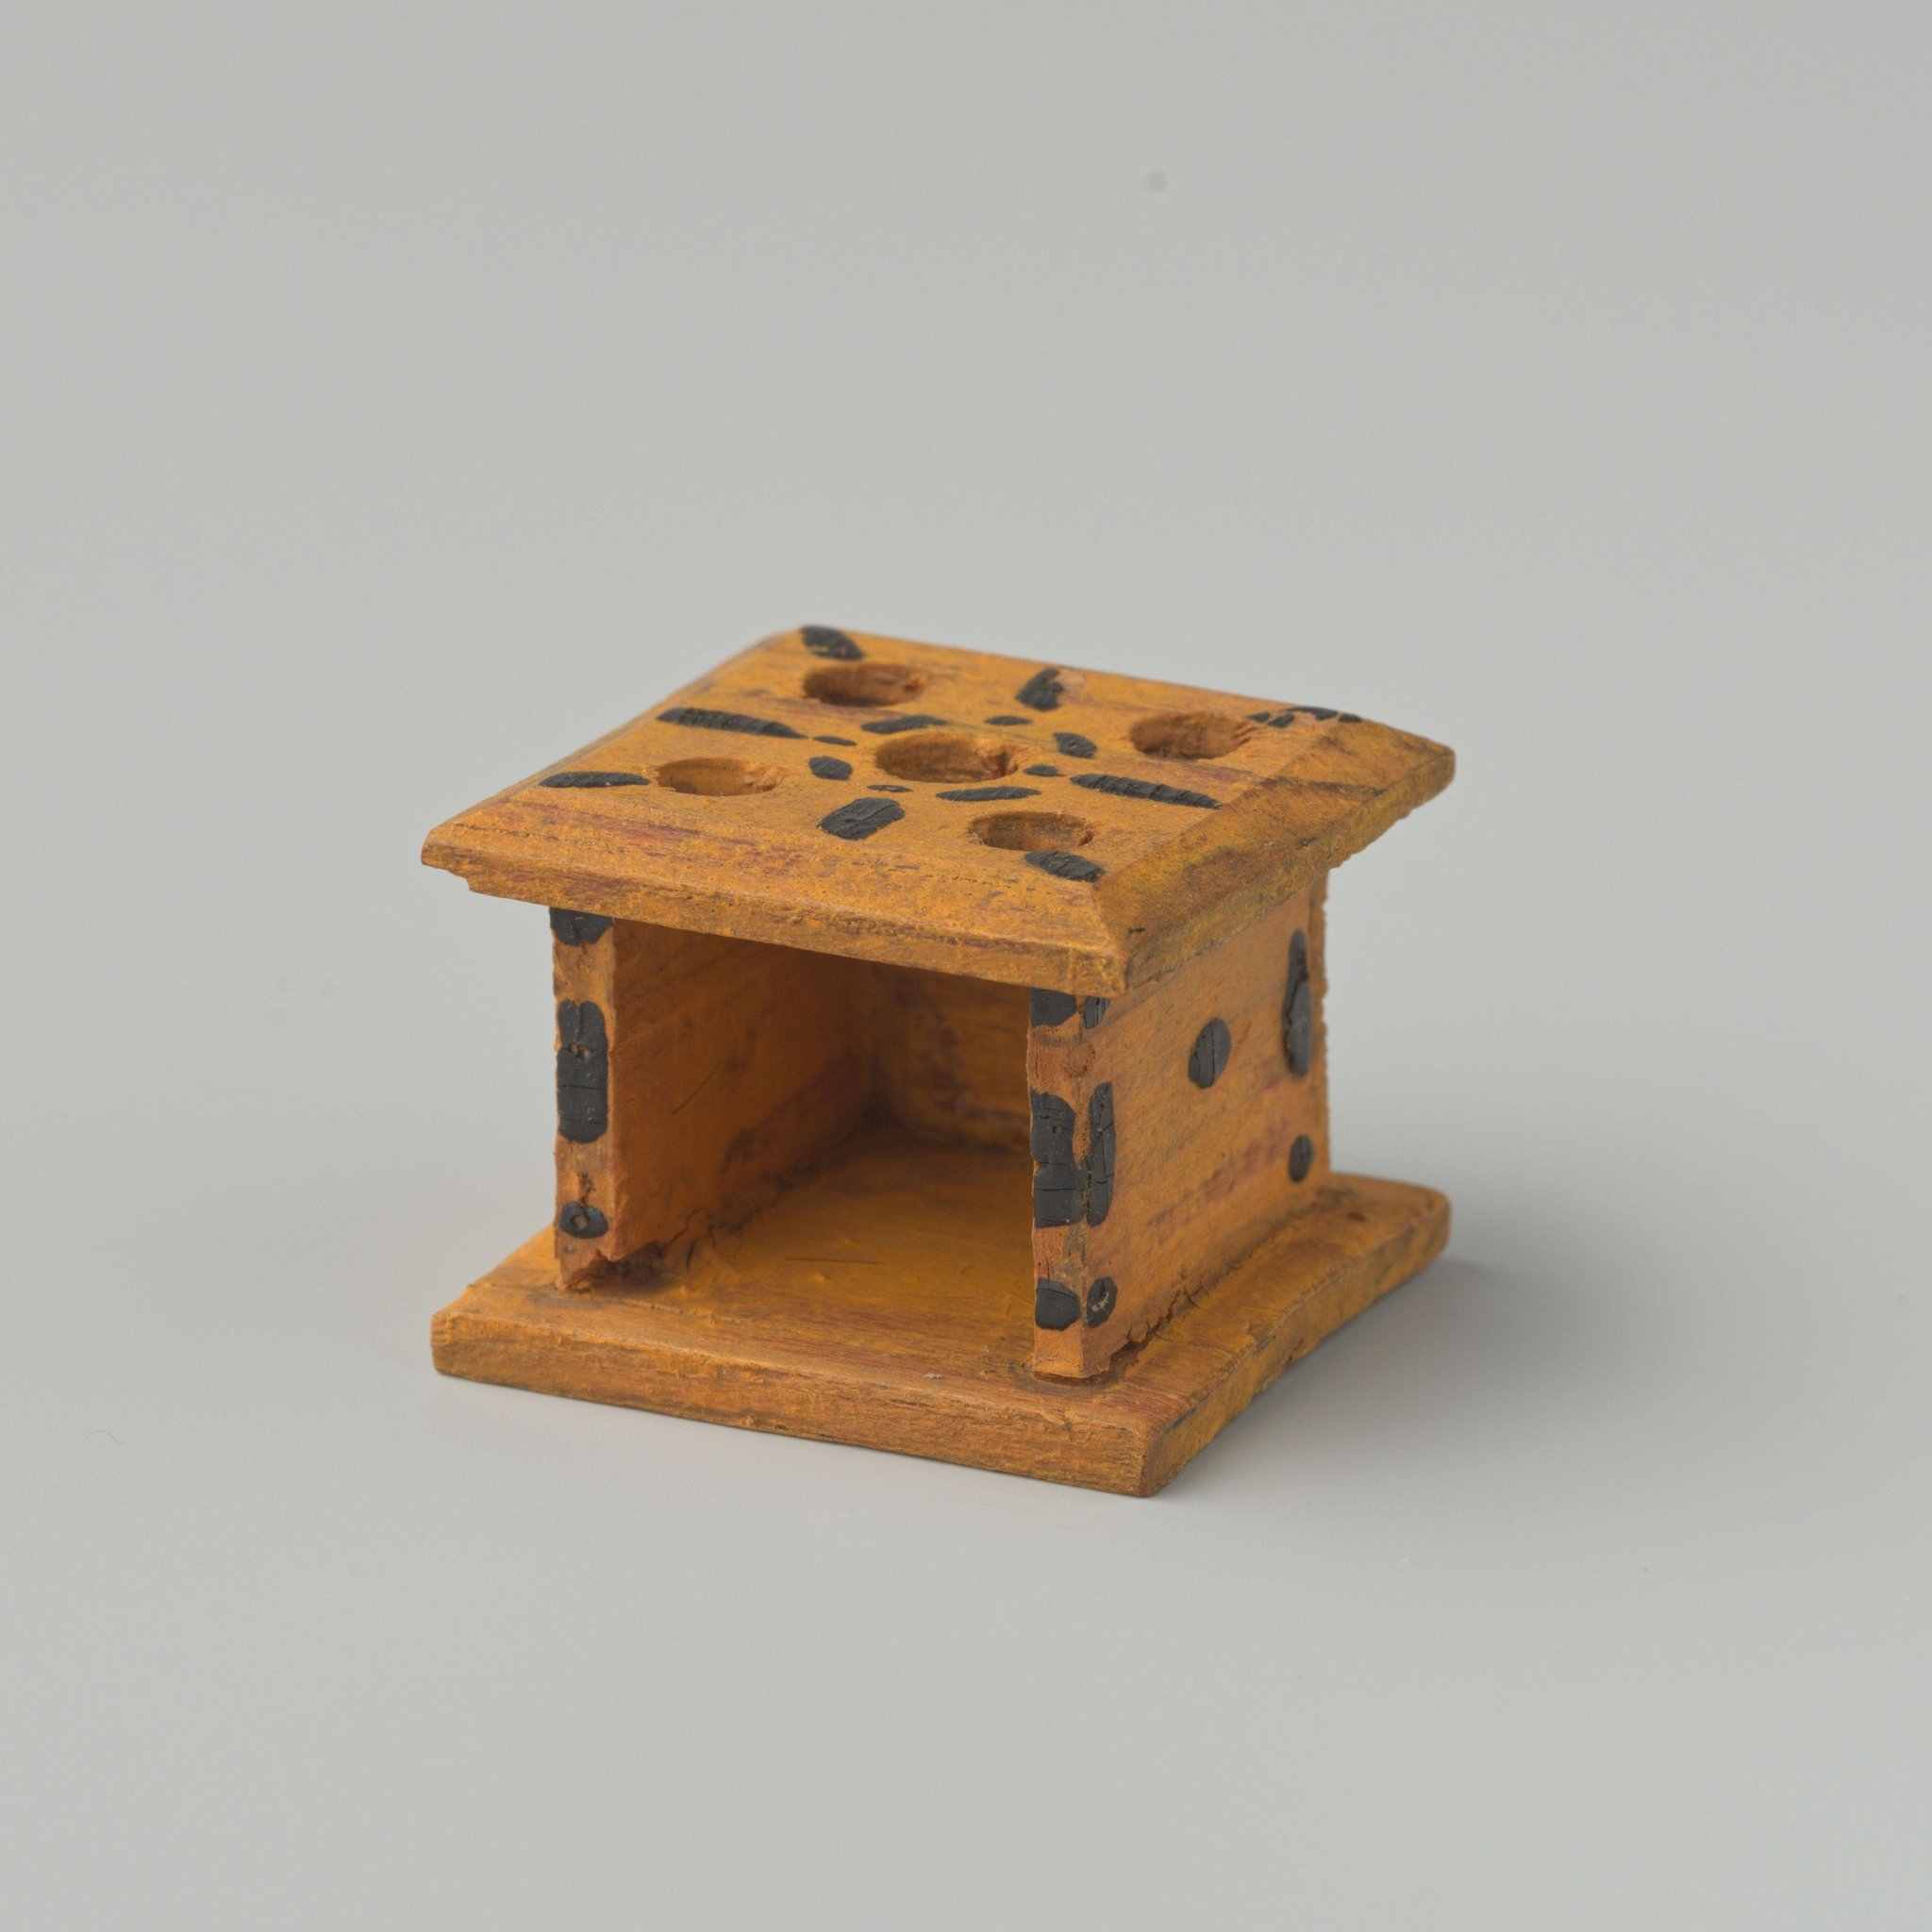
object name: voetstoof, stoof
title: Stoof, geel van kleur, versierd met zwarte stippen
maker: Anonymous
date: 1676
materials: without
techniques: without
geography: amsterdam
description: Stoof van without, vierkant van vorm. De geel gekleurde stoof is versierd met zwarte stippen. In de voetenplank zitten vijf gaten.